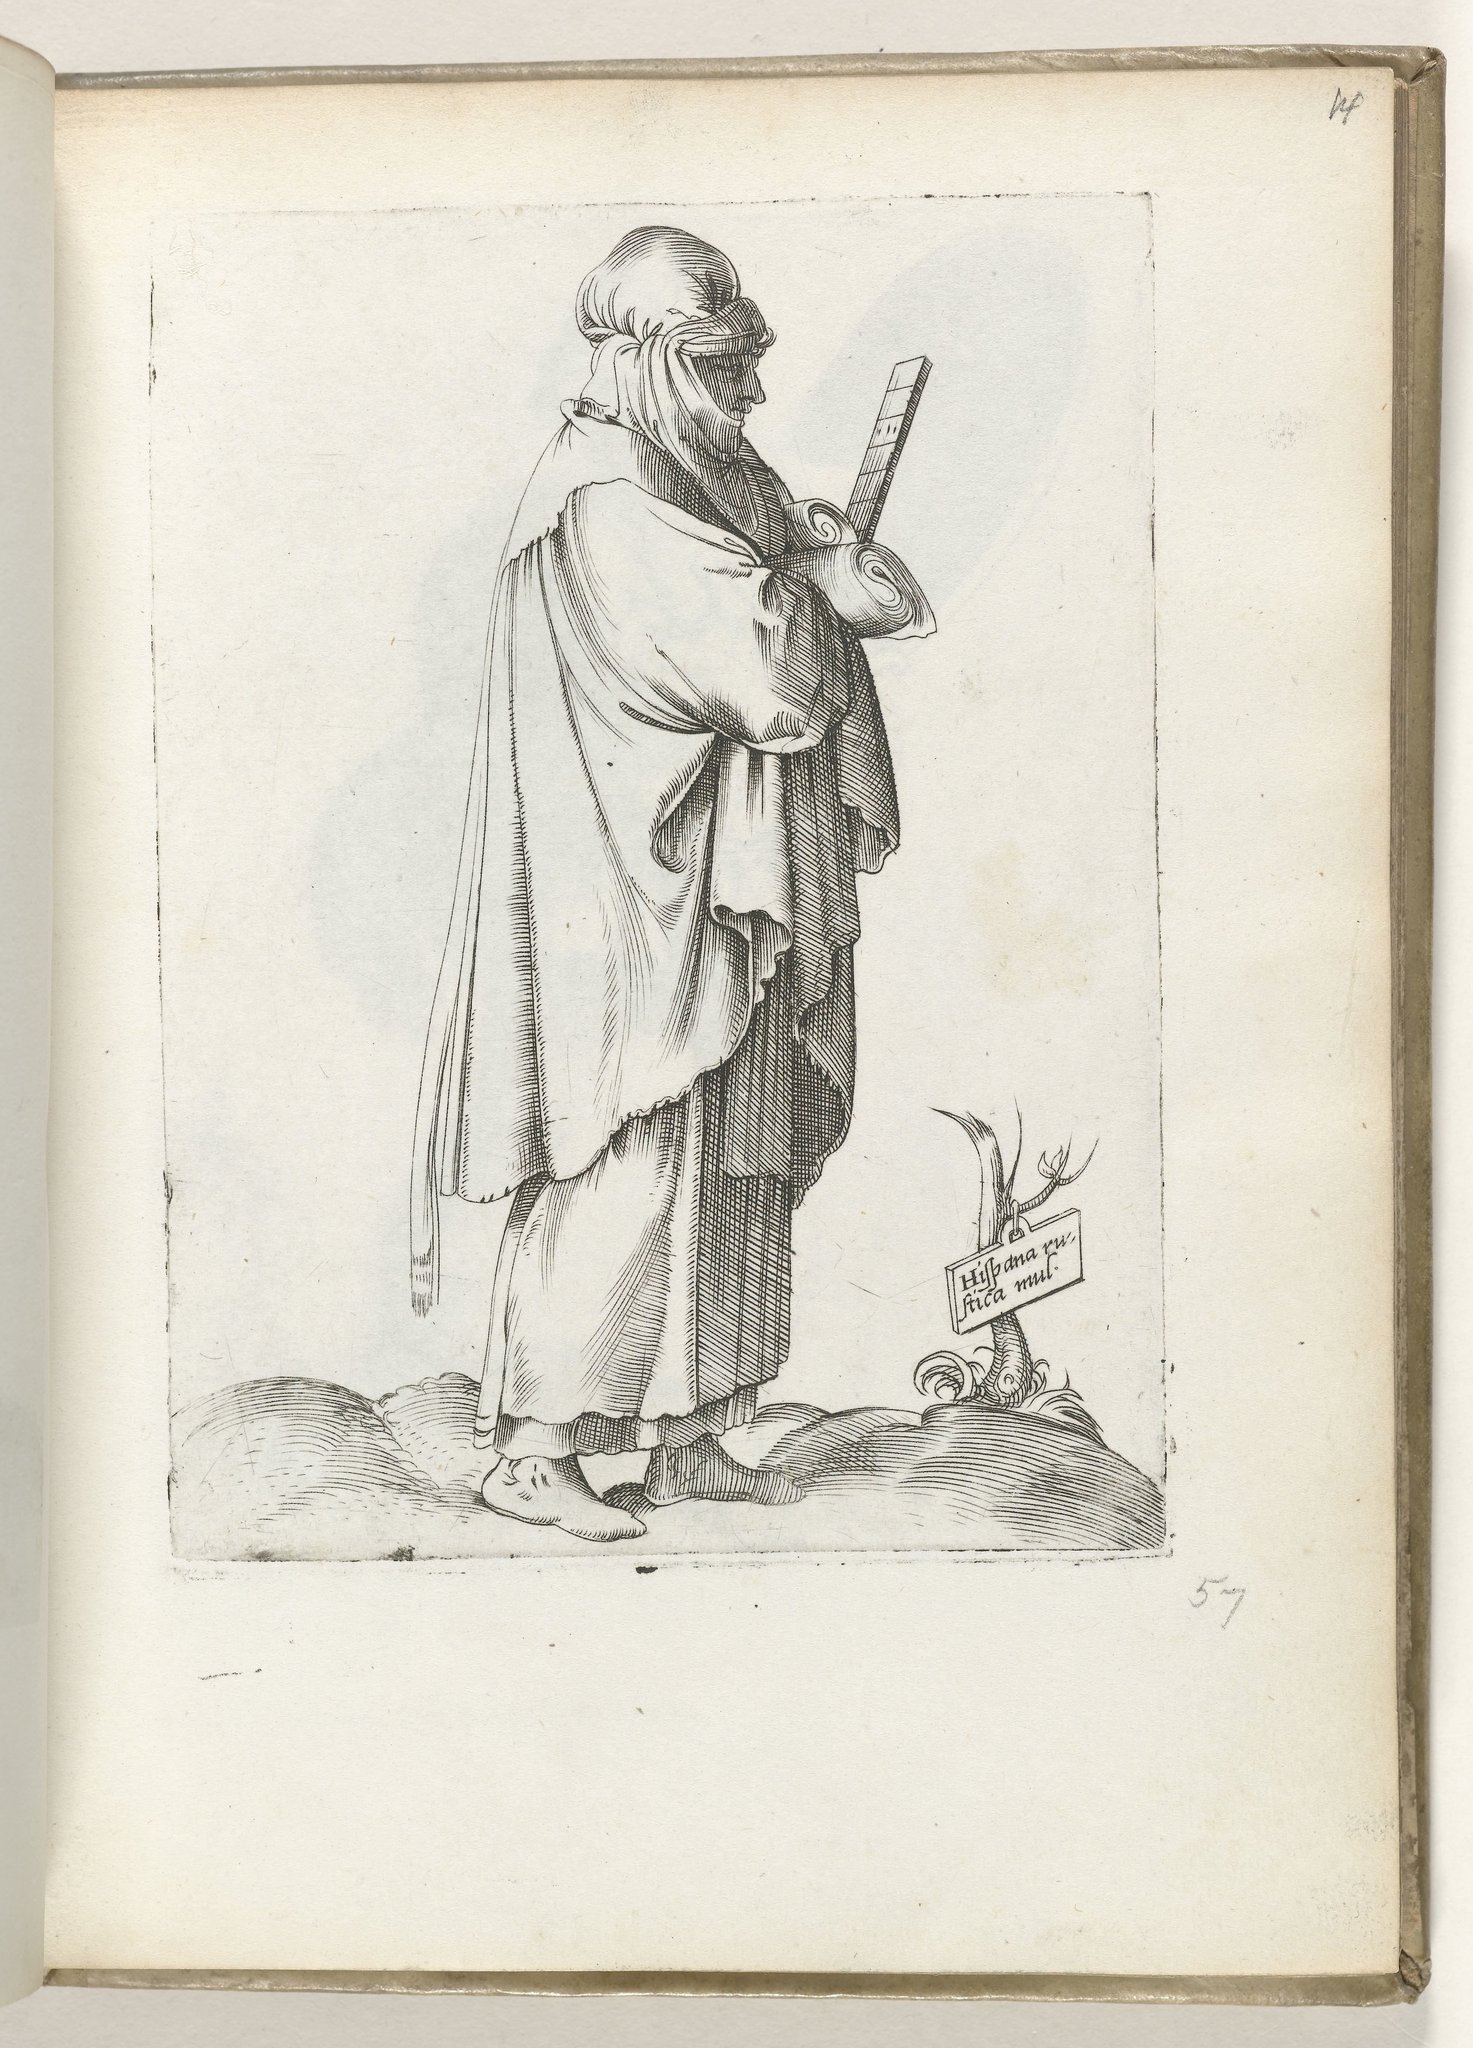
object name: costume print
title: Diversarum gentium nostrae aetatis habitus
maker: enea vico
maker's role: draughtsman, print maker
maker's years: 1523-1567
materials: paper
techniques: engraving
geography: venice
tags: europeans: spaniards (+ costume)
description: Vrouw naar rechts, met rol stof en plankje in de armen. Prent uit album 'Diversarum gentium nostrae aetatis habitus'.